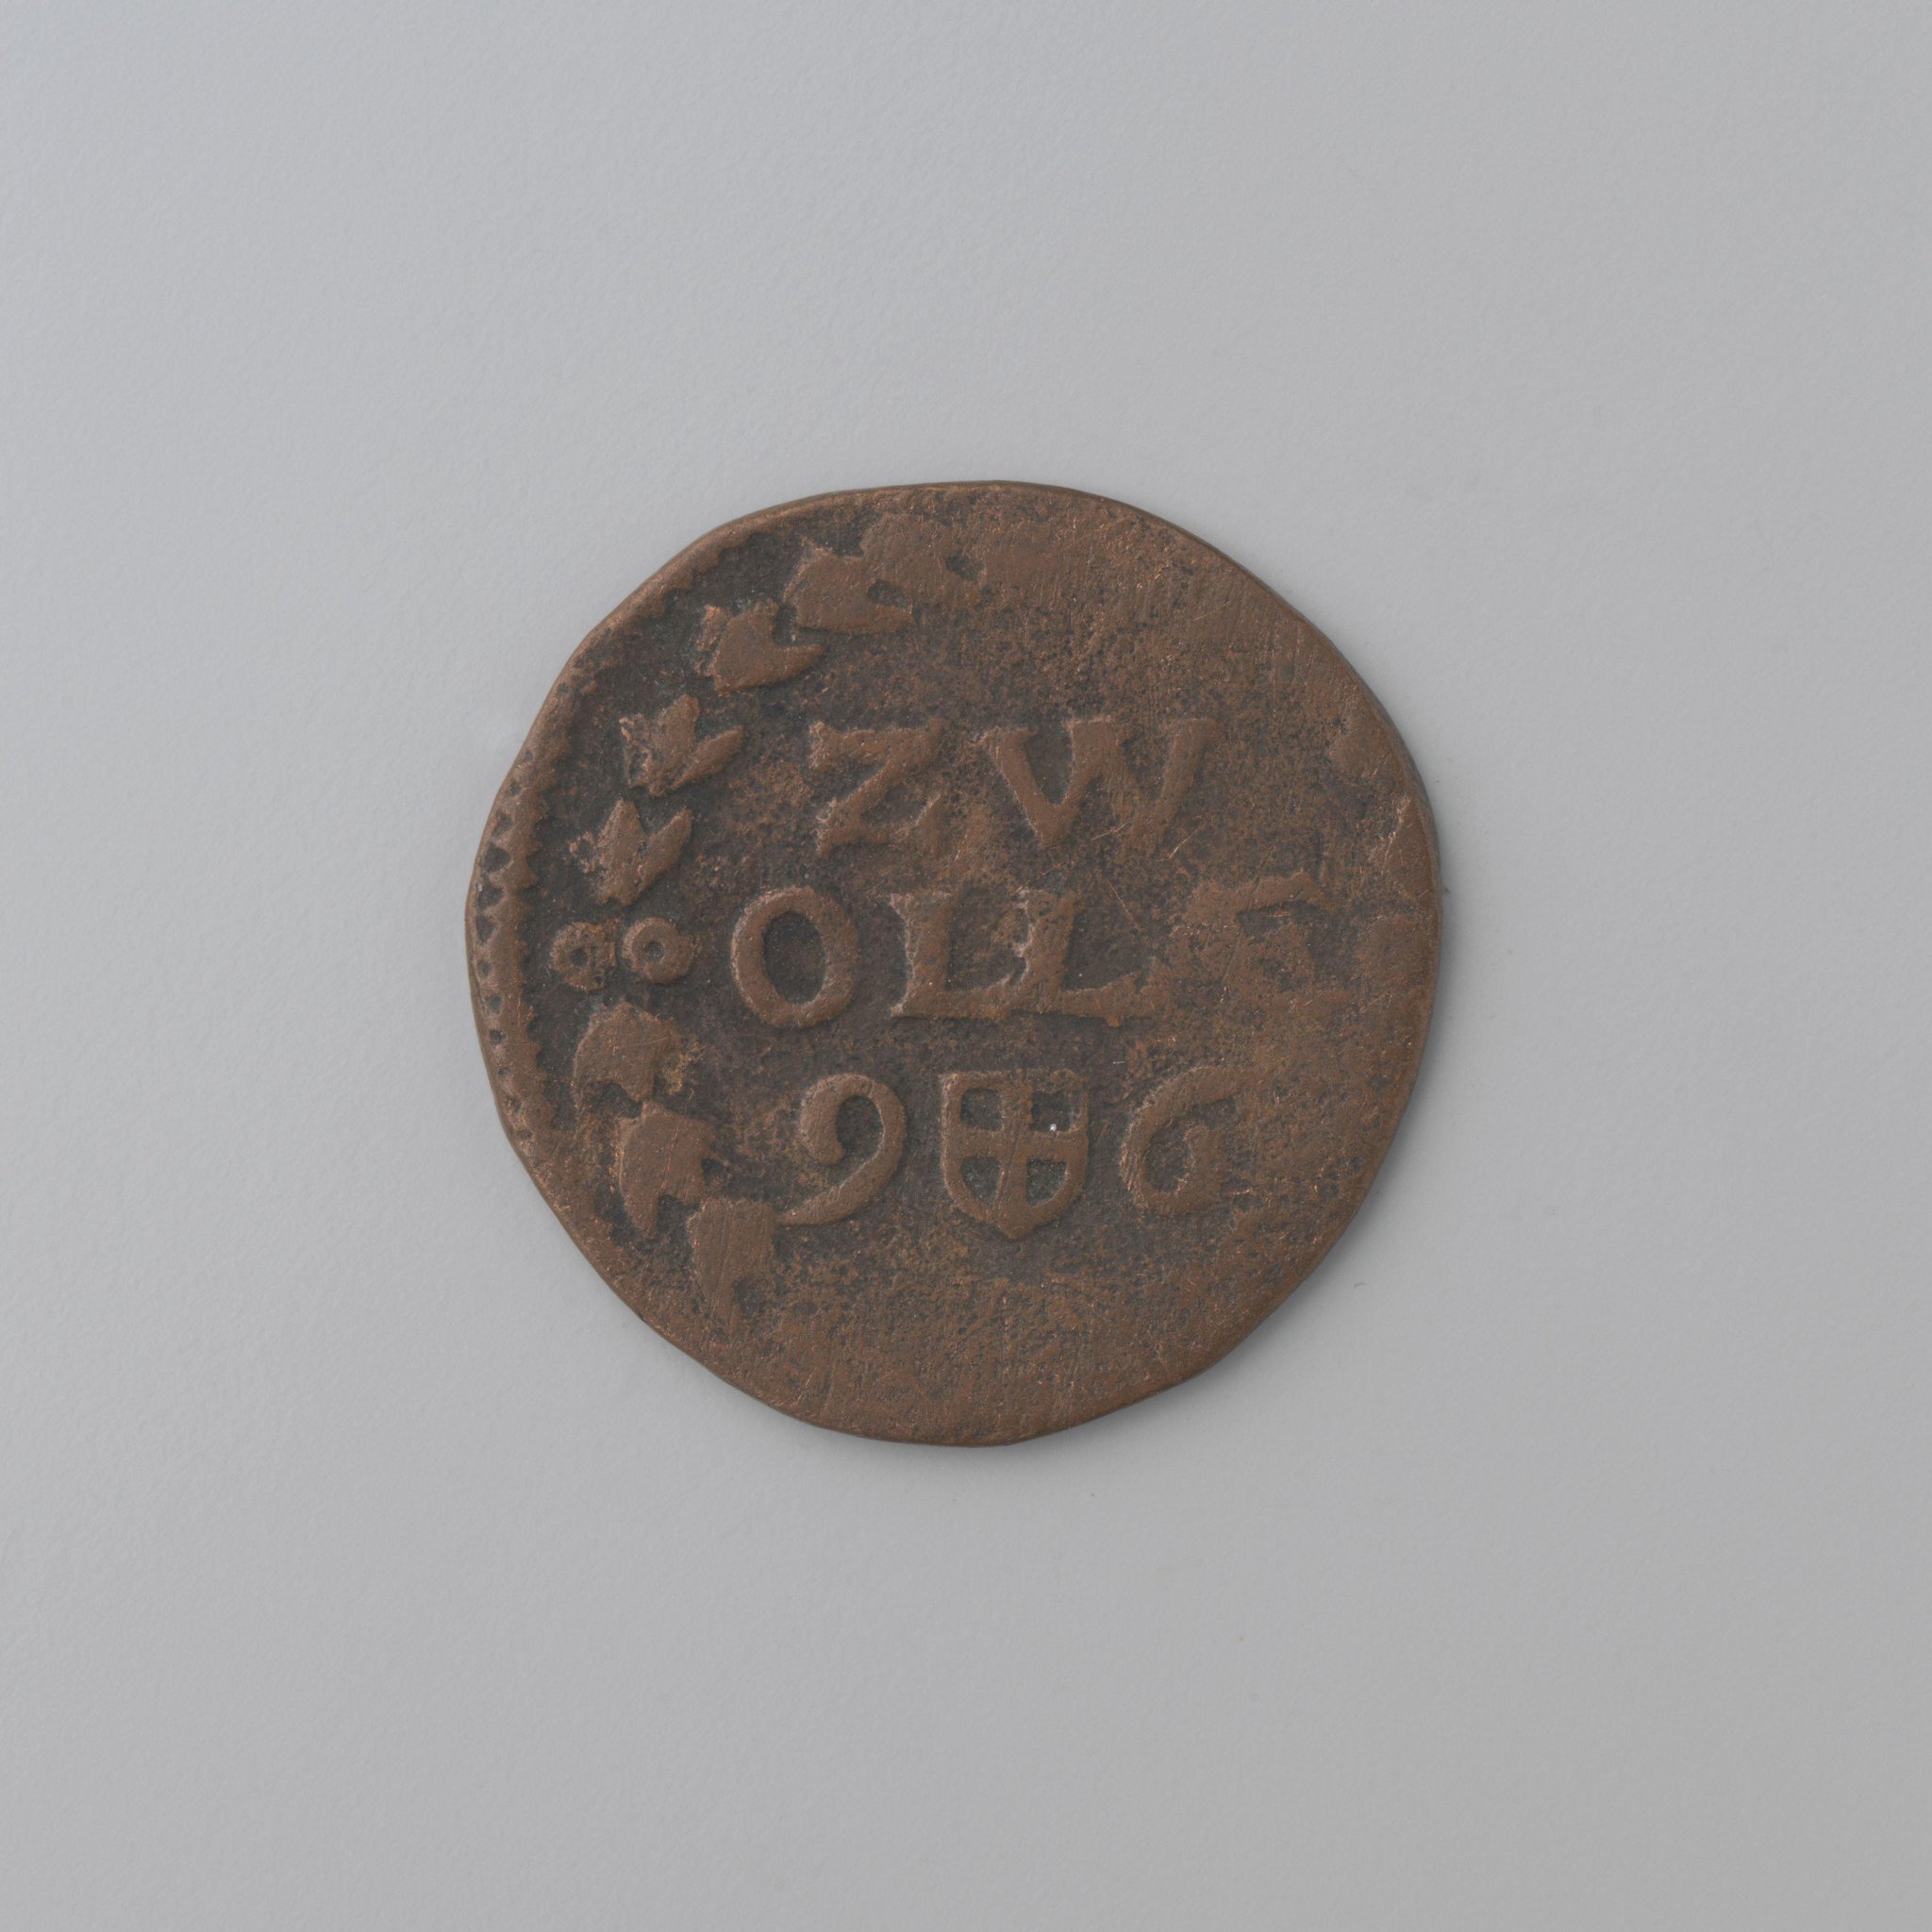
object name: coin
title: Zwolse duit, 1596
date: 1596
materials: copper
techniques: striking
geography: zwolle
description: Koperen munt. Voorzijde: wapenschild van Zwolle. Keerzijde: binnen krans tweeregelig opschrift, waaronder jaartal 96 tussen wapenschildje.